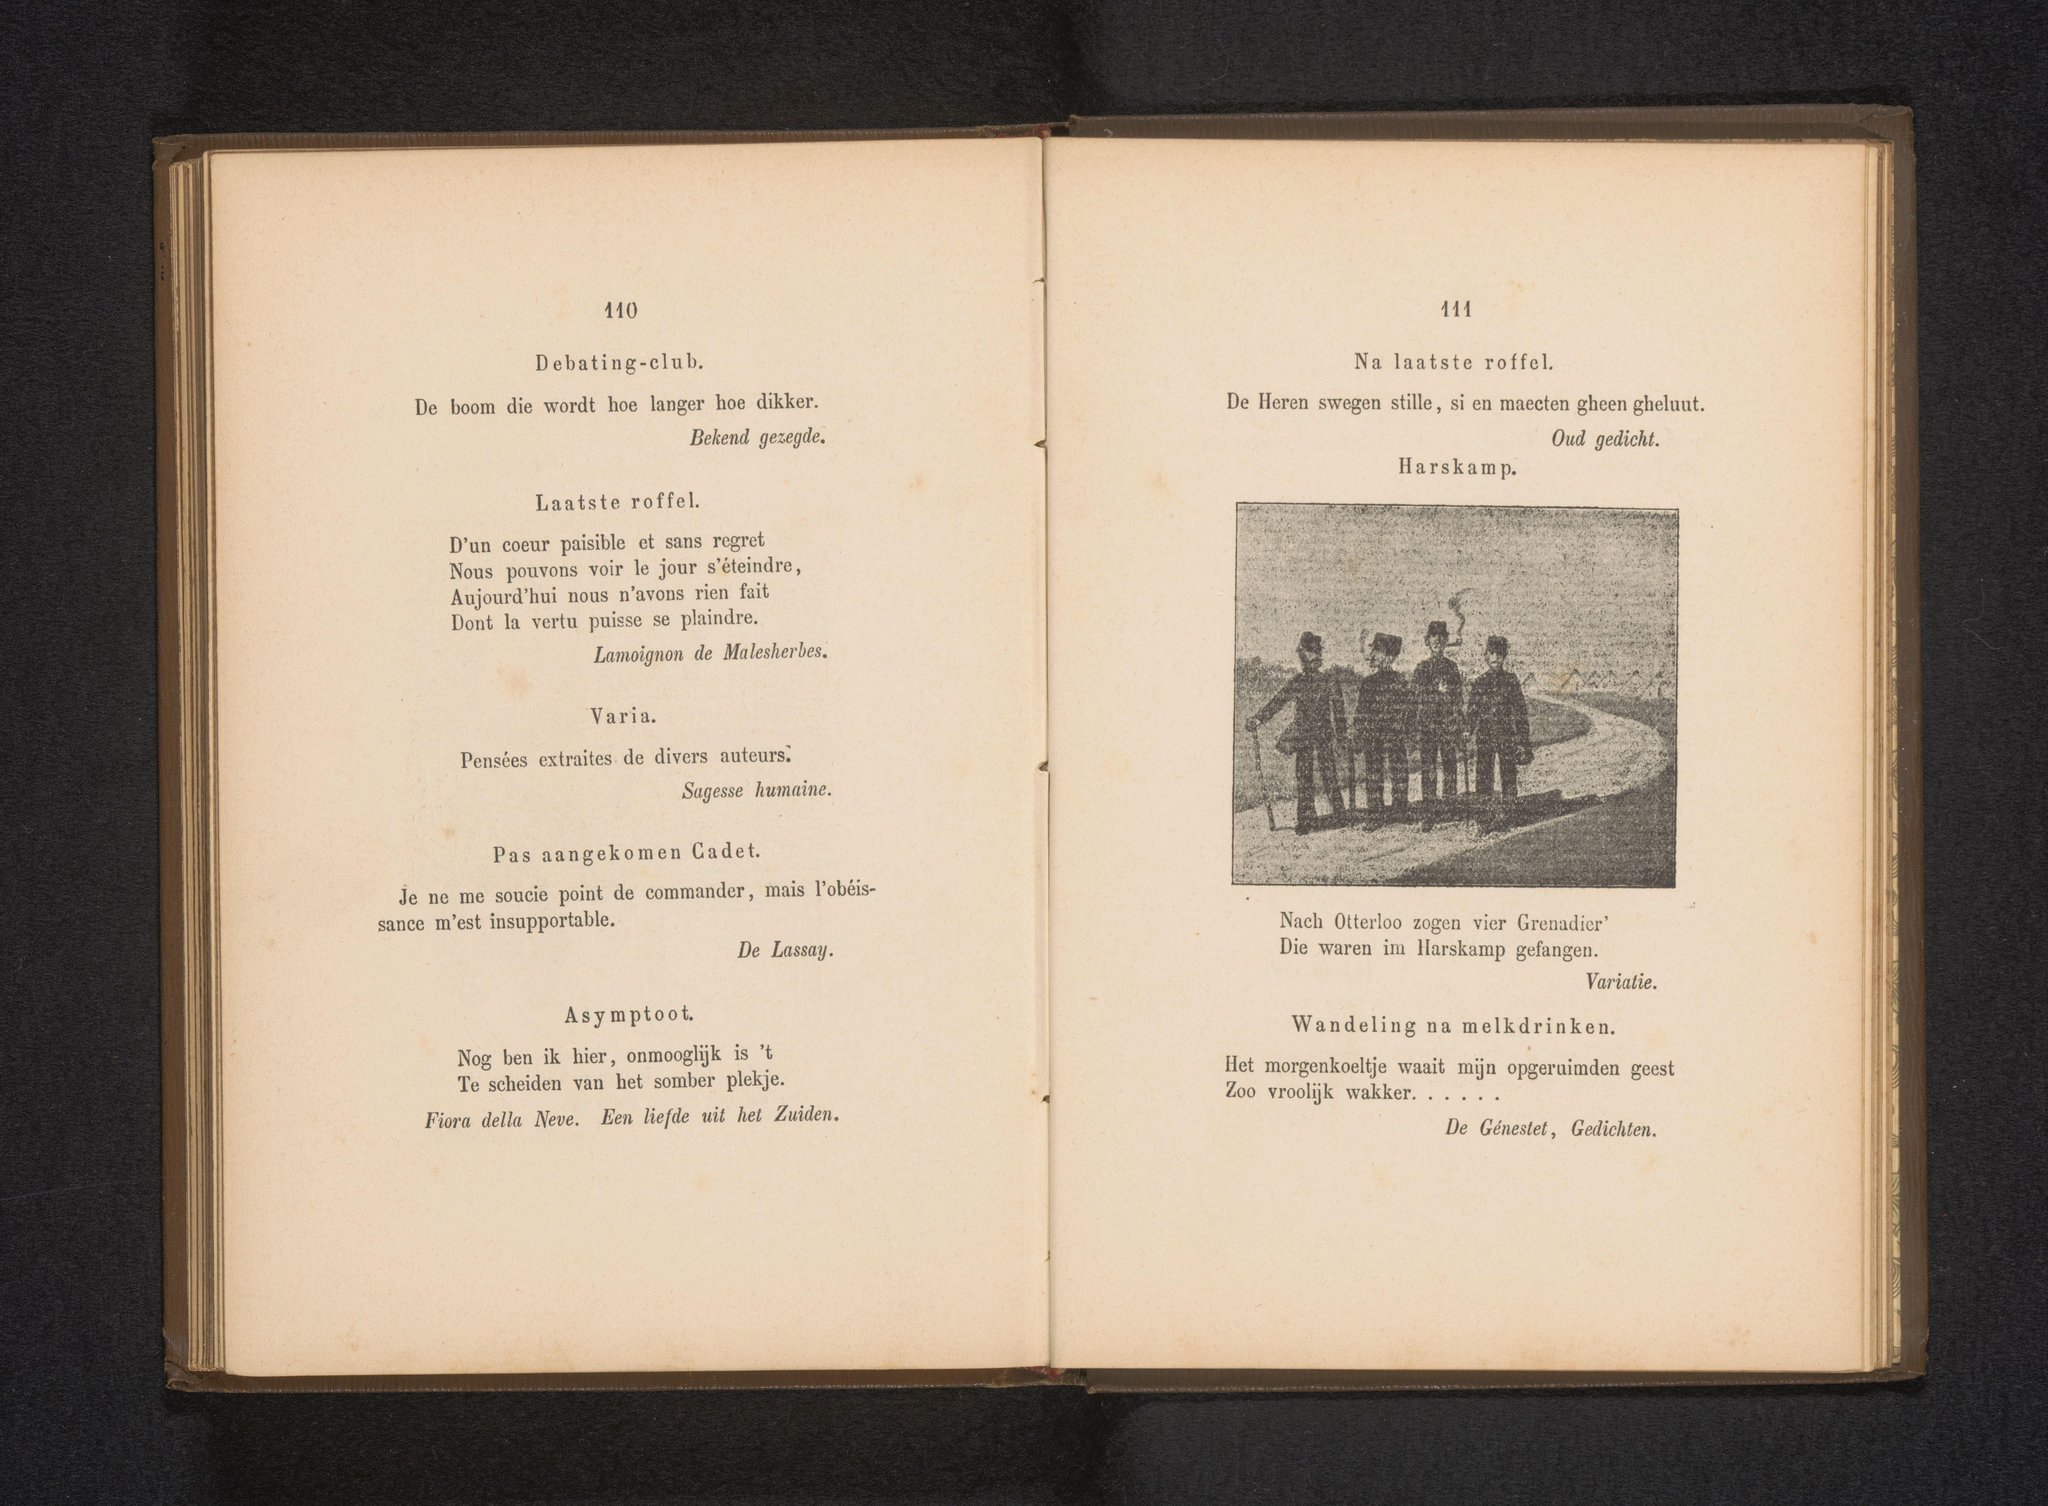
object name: reproduction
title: Reproductie van een tekening van vier soldaten op een weg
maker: Anonymous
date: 1898-1903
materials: paper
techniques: autotype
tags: private soldier